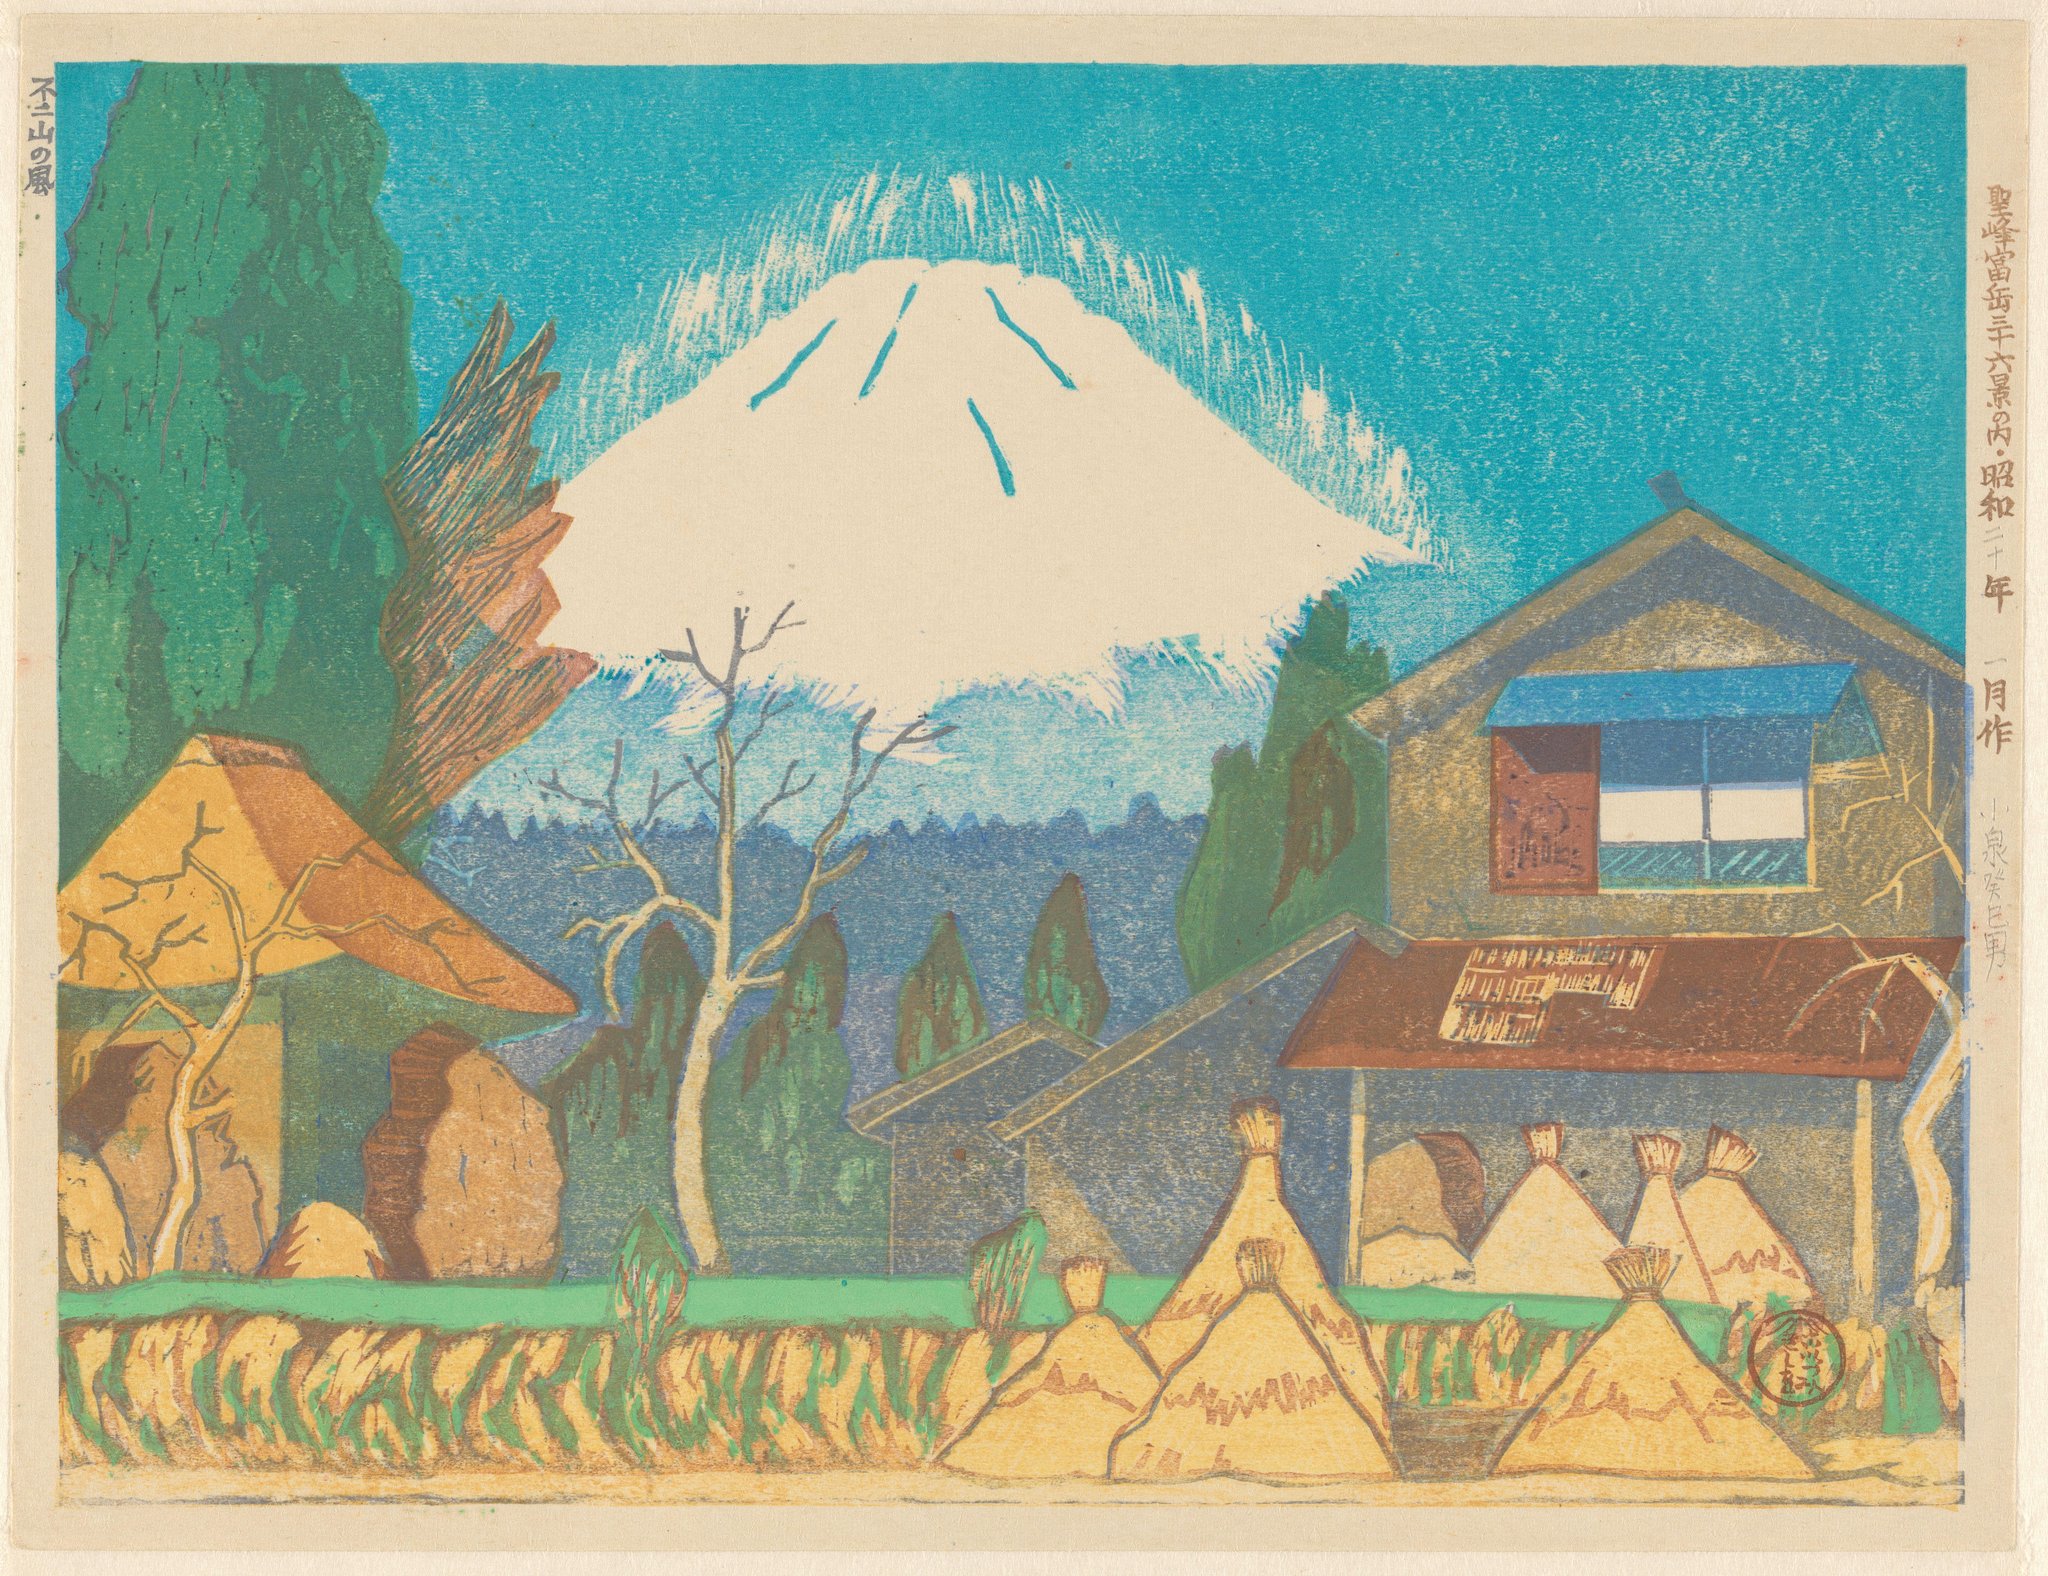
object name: print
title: Wind on Mount Fuji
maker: koizumi kishio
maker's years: 1893-1945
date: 1901-1945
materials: paper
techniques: woodcut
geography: japan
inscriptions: signature: ‘小泉癸巳男’, seal: ‘こいづみきしを’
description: De hoge besneeuwde Fuji-berg steekt op tegen een felblauwe lucht in dit stille dorpsgezicht. Een bijzonder wolkenpatroon is zichtbaar rondom de piek. Koizumi Kishio begon in 1940 aan zijn project 'Zesendertig gezichten op de heilige berg Fuji', een knipoog naar de welbekende prenten uit de jaren 1830 van Katsushika Hokusai (1760–1849). Vanwege de geallieerde bombardementen vluchtte hij naar zijn schoonouders in Saitama, ten noorden van Tokyo. Hij voltooide 23 ontwerpen voor hij bezweek aan ziekte in 1945.